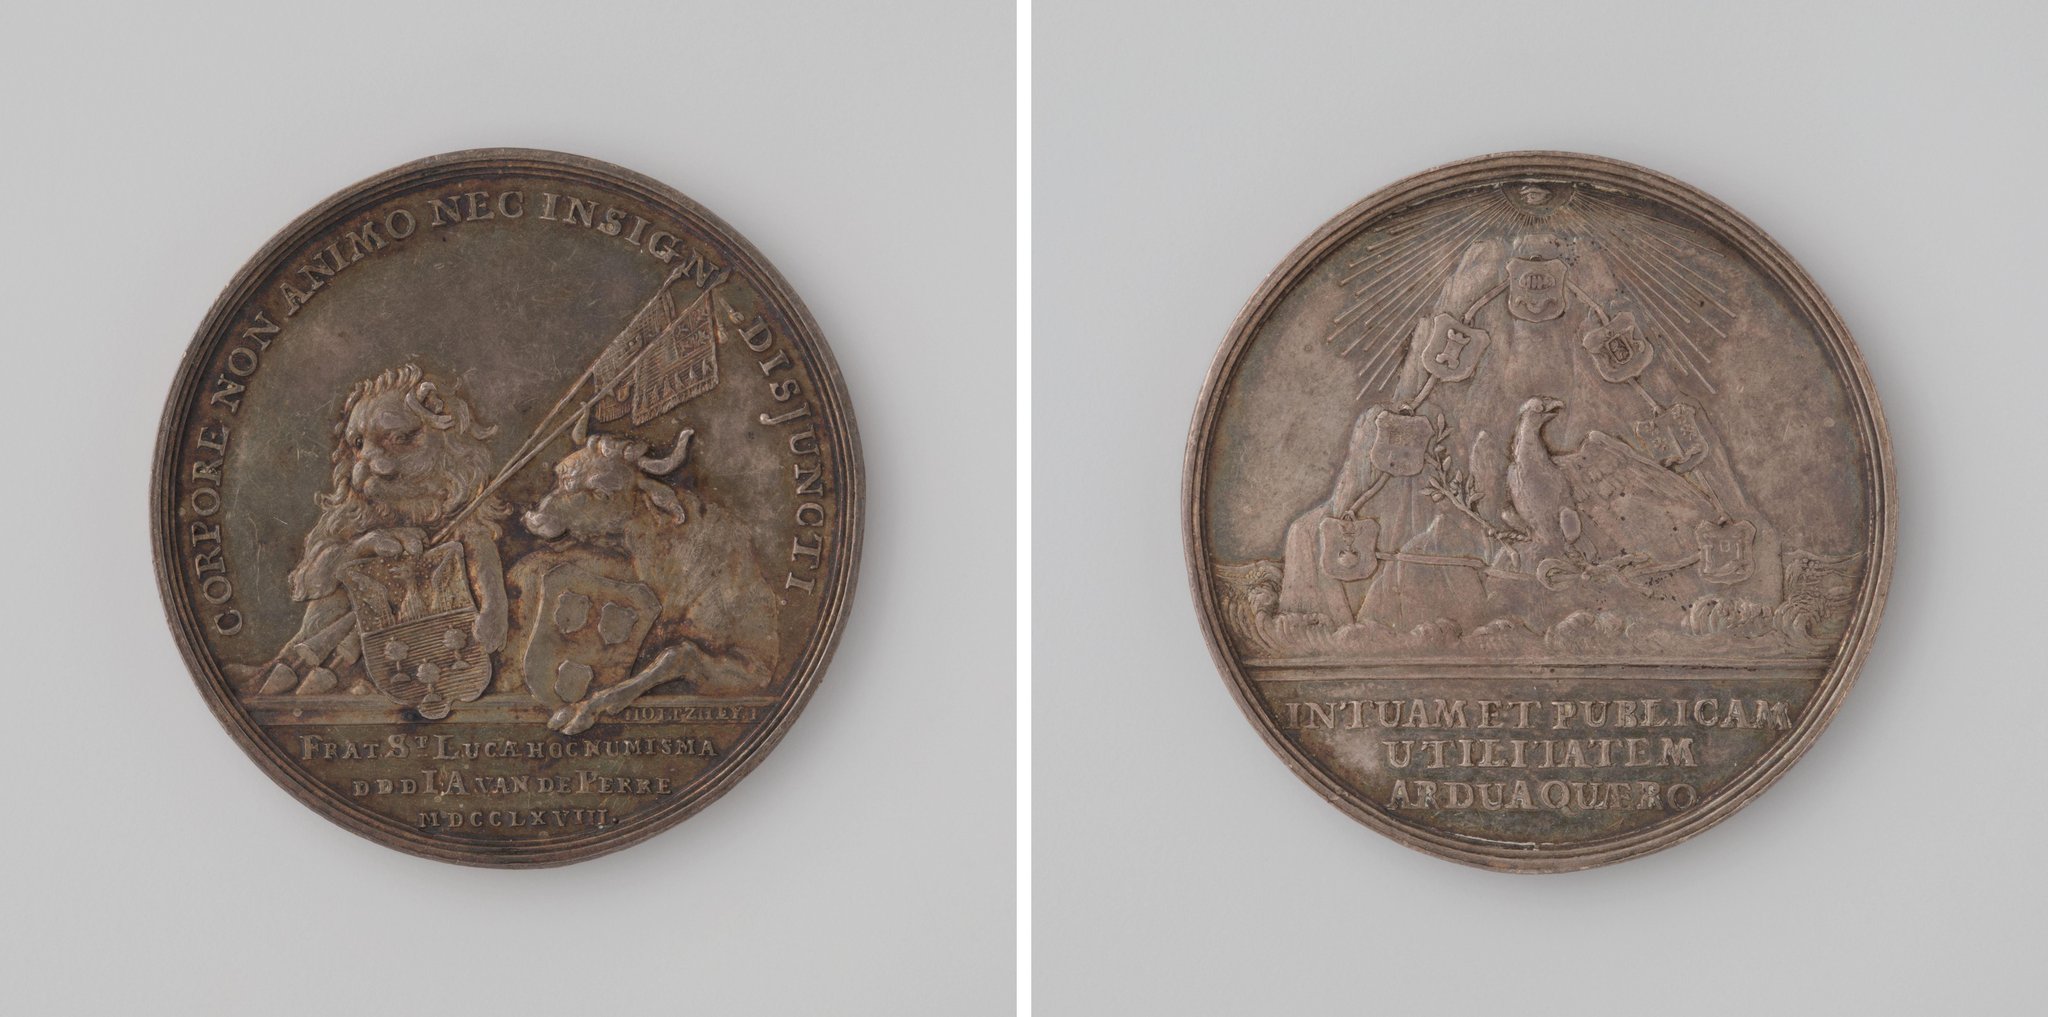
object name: history medal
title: Johan Adriaan van de Perre, heer van Nieuwerve en Welsingen, benoemd tot eerste edele van Zeeland, penning geschonken door het St. Lukasgilde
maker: johan george holtzhey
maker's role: mintmaster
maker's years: 1726-1808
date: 1768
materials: silver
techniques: striking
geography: amsterdam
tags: zeeland